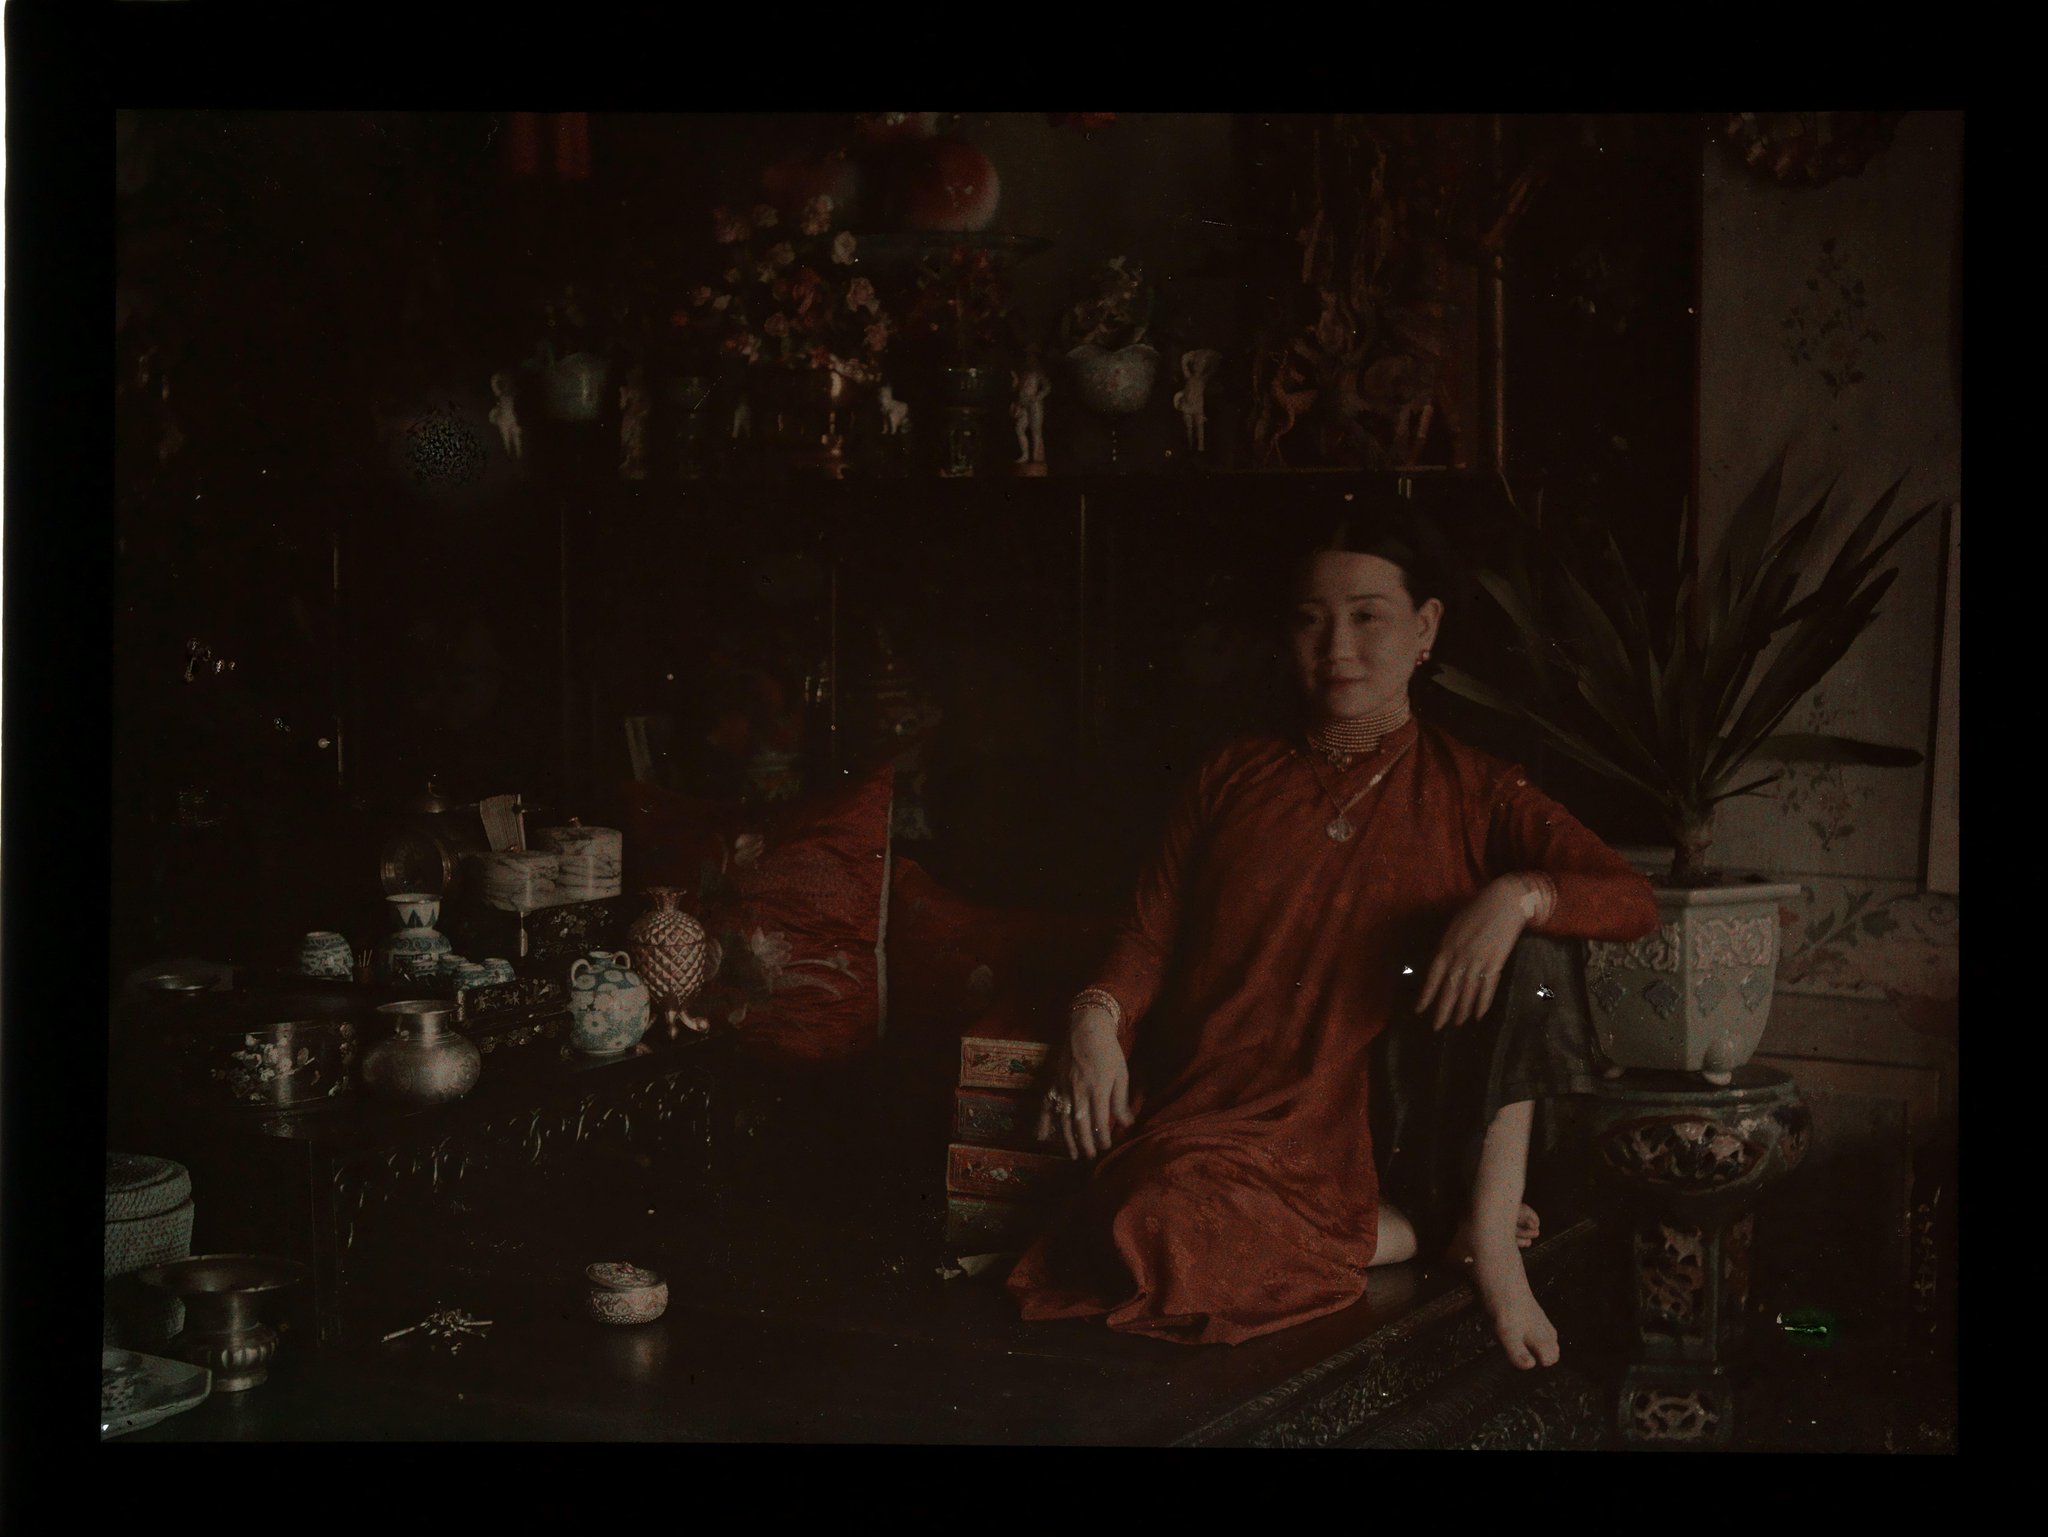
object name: photograph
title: Zittende Chinese vrouw in een interieur met Aziatische voorwerpen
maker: Anonymous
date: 1910-1940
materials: glass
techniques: autochrome process